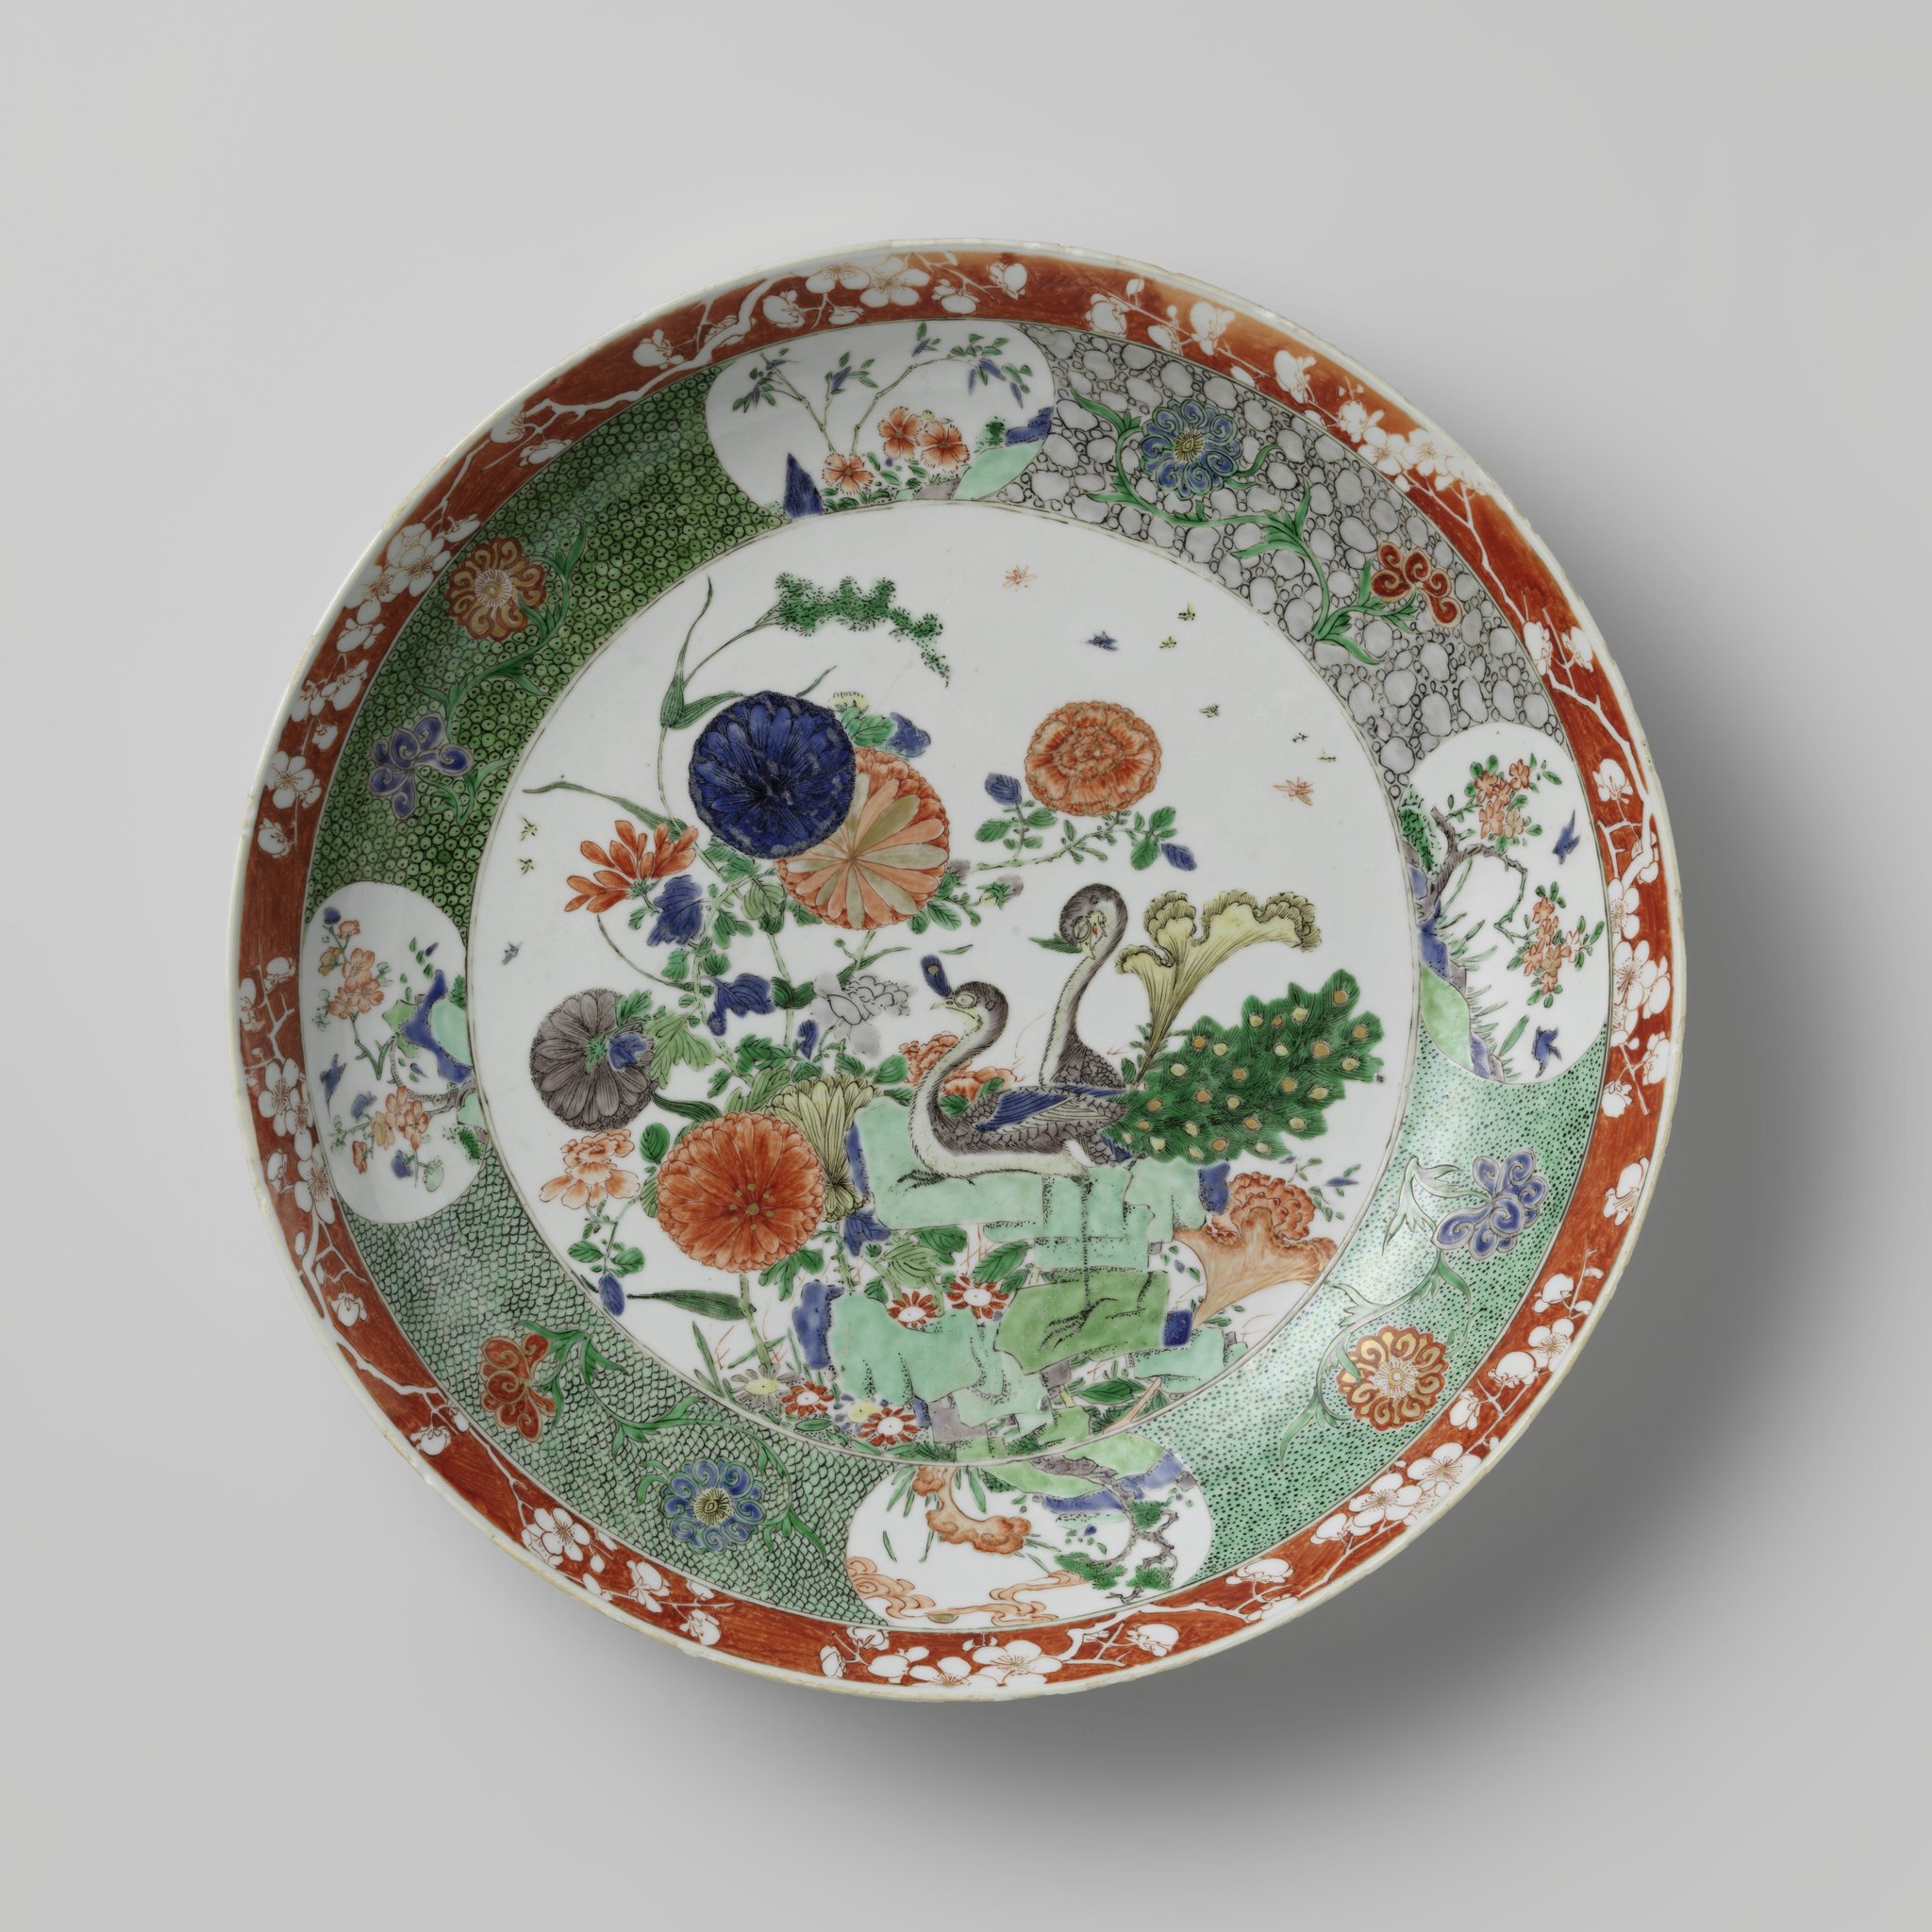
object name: platter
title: Saucer-dish with two peacocks, rocks and flowering plants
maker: Anonymous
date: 1700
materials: cobalt, glaze, paint, porcelain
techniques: firing, turning, vitrification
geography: china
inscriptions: mark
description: Schotel in 'famille verte' kleuren. Op het plat 2 pauwen op een rots. Op de rand vier reserves met bloemtakken. Hier omheen een rand met prunus-takken.